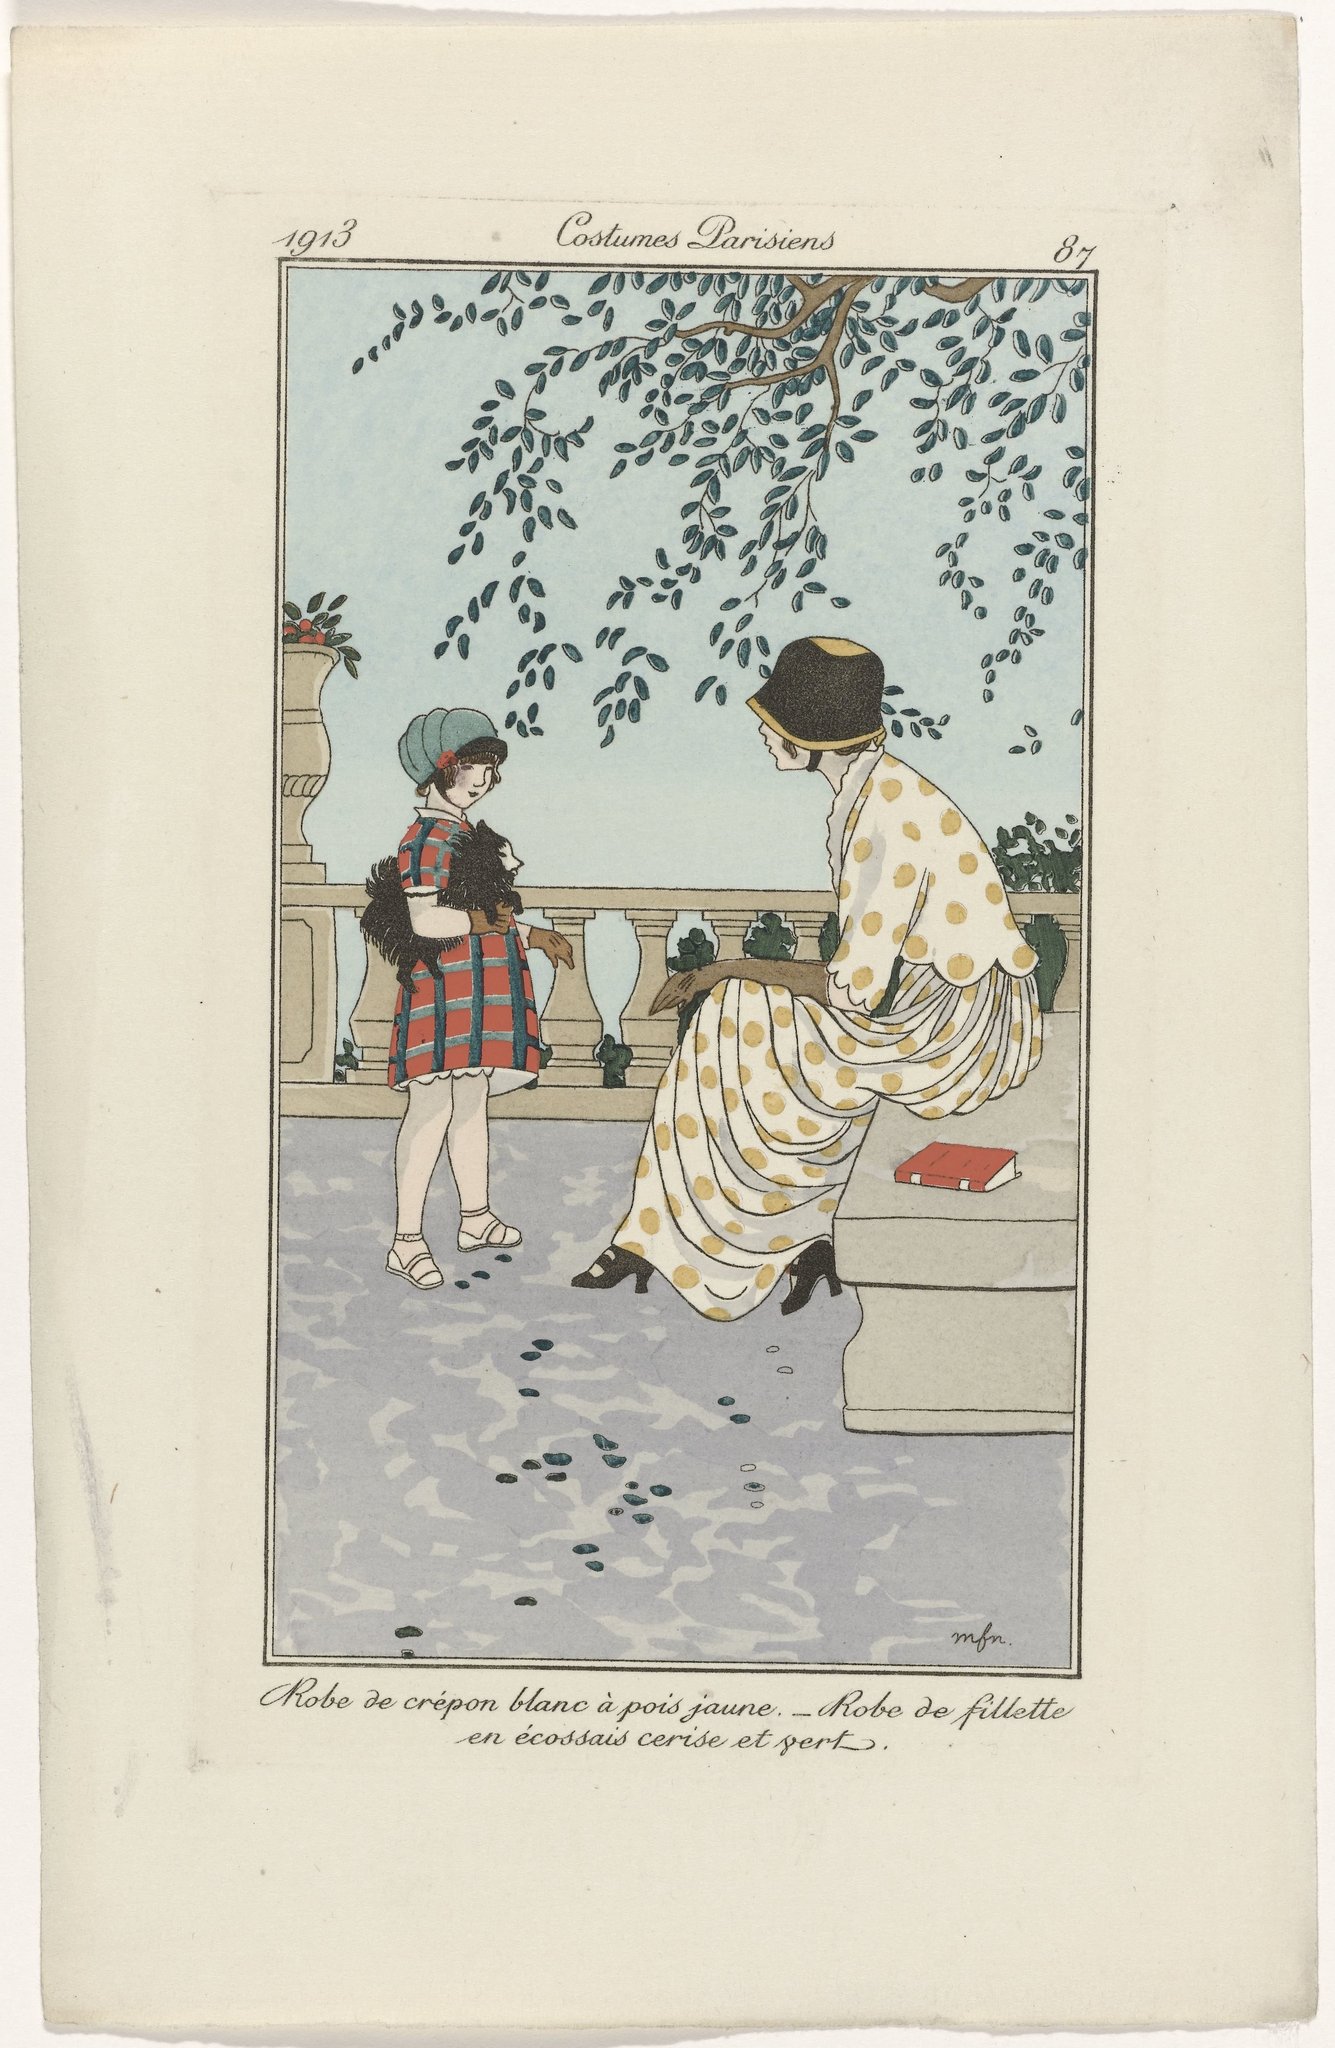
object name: fashion print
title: Journal des Dames et des Modes: Fashion News Journal des Dames et des Modes: the Fashion Illustrators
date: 1913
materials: paper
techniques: engraving, hand coloring, pochoir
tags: head-gear (+ girls' clothes), walking the dog (+ variant), fashion plates, dress, gown (+ women's clothes), balustrade, book, dress, gown (+ girls' clothes)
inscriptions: caption: ‘Robe de crépon blanc à pois jaune._ Robe de fillette en écossais cerise et vert.’, title: ‘Costumes Parisiens’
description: The Journal des Dames was inspired by the eponymous fashion magazine from the previous century and, like the earlier publication, referred to its illustrations as Costumes Parisiens. These Costumes Parisiens (184 illustrations in total) were drawn in a new, flat, decorative manner by George Barbier, Jan van Brock, Victor Lhuer and other Parisian artists, each with a signature style. Every issue came with two or three separate plates. These showed a wide variety of fashionable apparel, from elegant evening attire to outdoor outfits. A brief caption provides the name of the garment and the material from which it was made, but never the name of a fashion house.